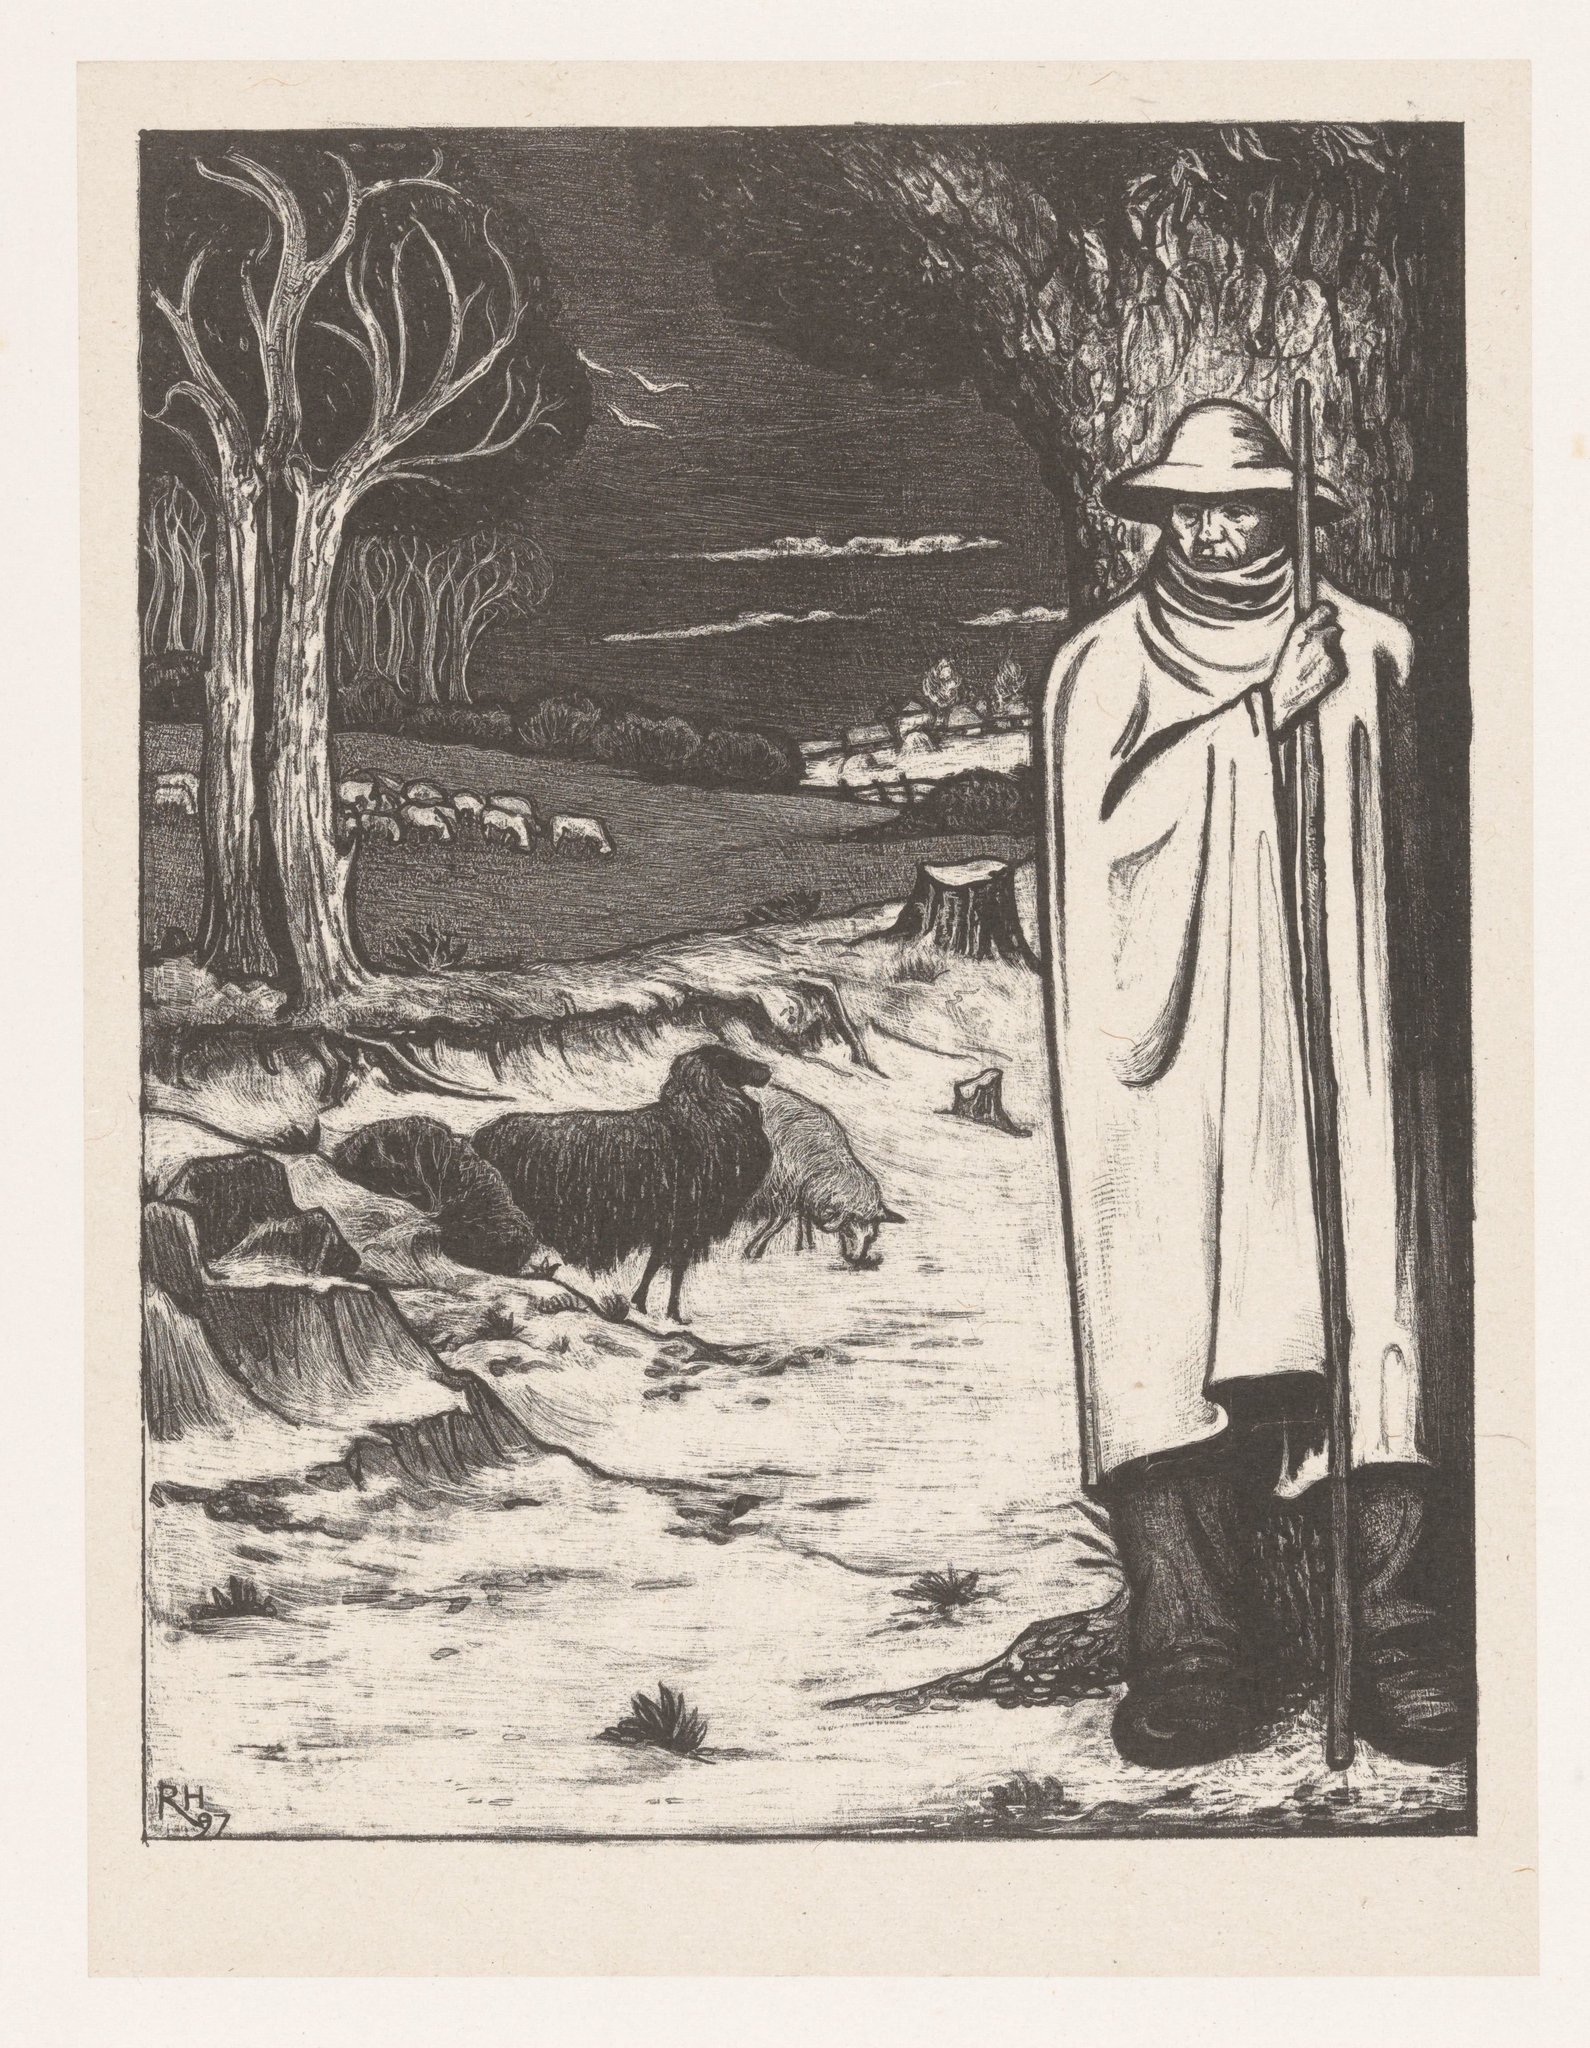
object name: print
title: Herder met een kudde schapen in een heuvellandschap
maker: richard nicolaüs roland holst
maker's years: 1868-1938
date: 1897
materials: paper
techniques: lithograph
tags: herding, herdsman, herdswoman, shepherd, shepherdess, cowherd, etc., sheep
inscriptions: collector's mark: Lugt 2228